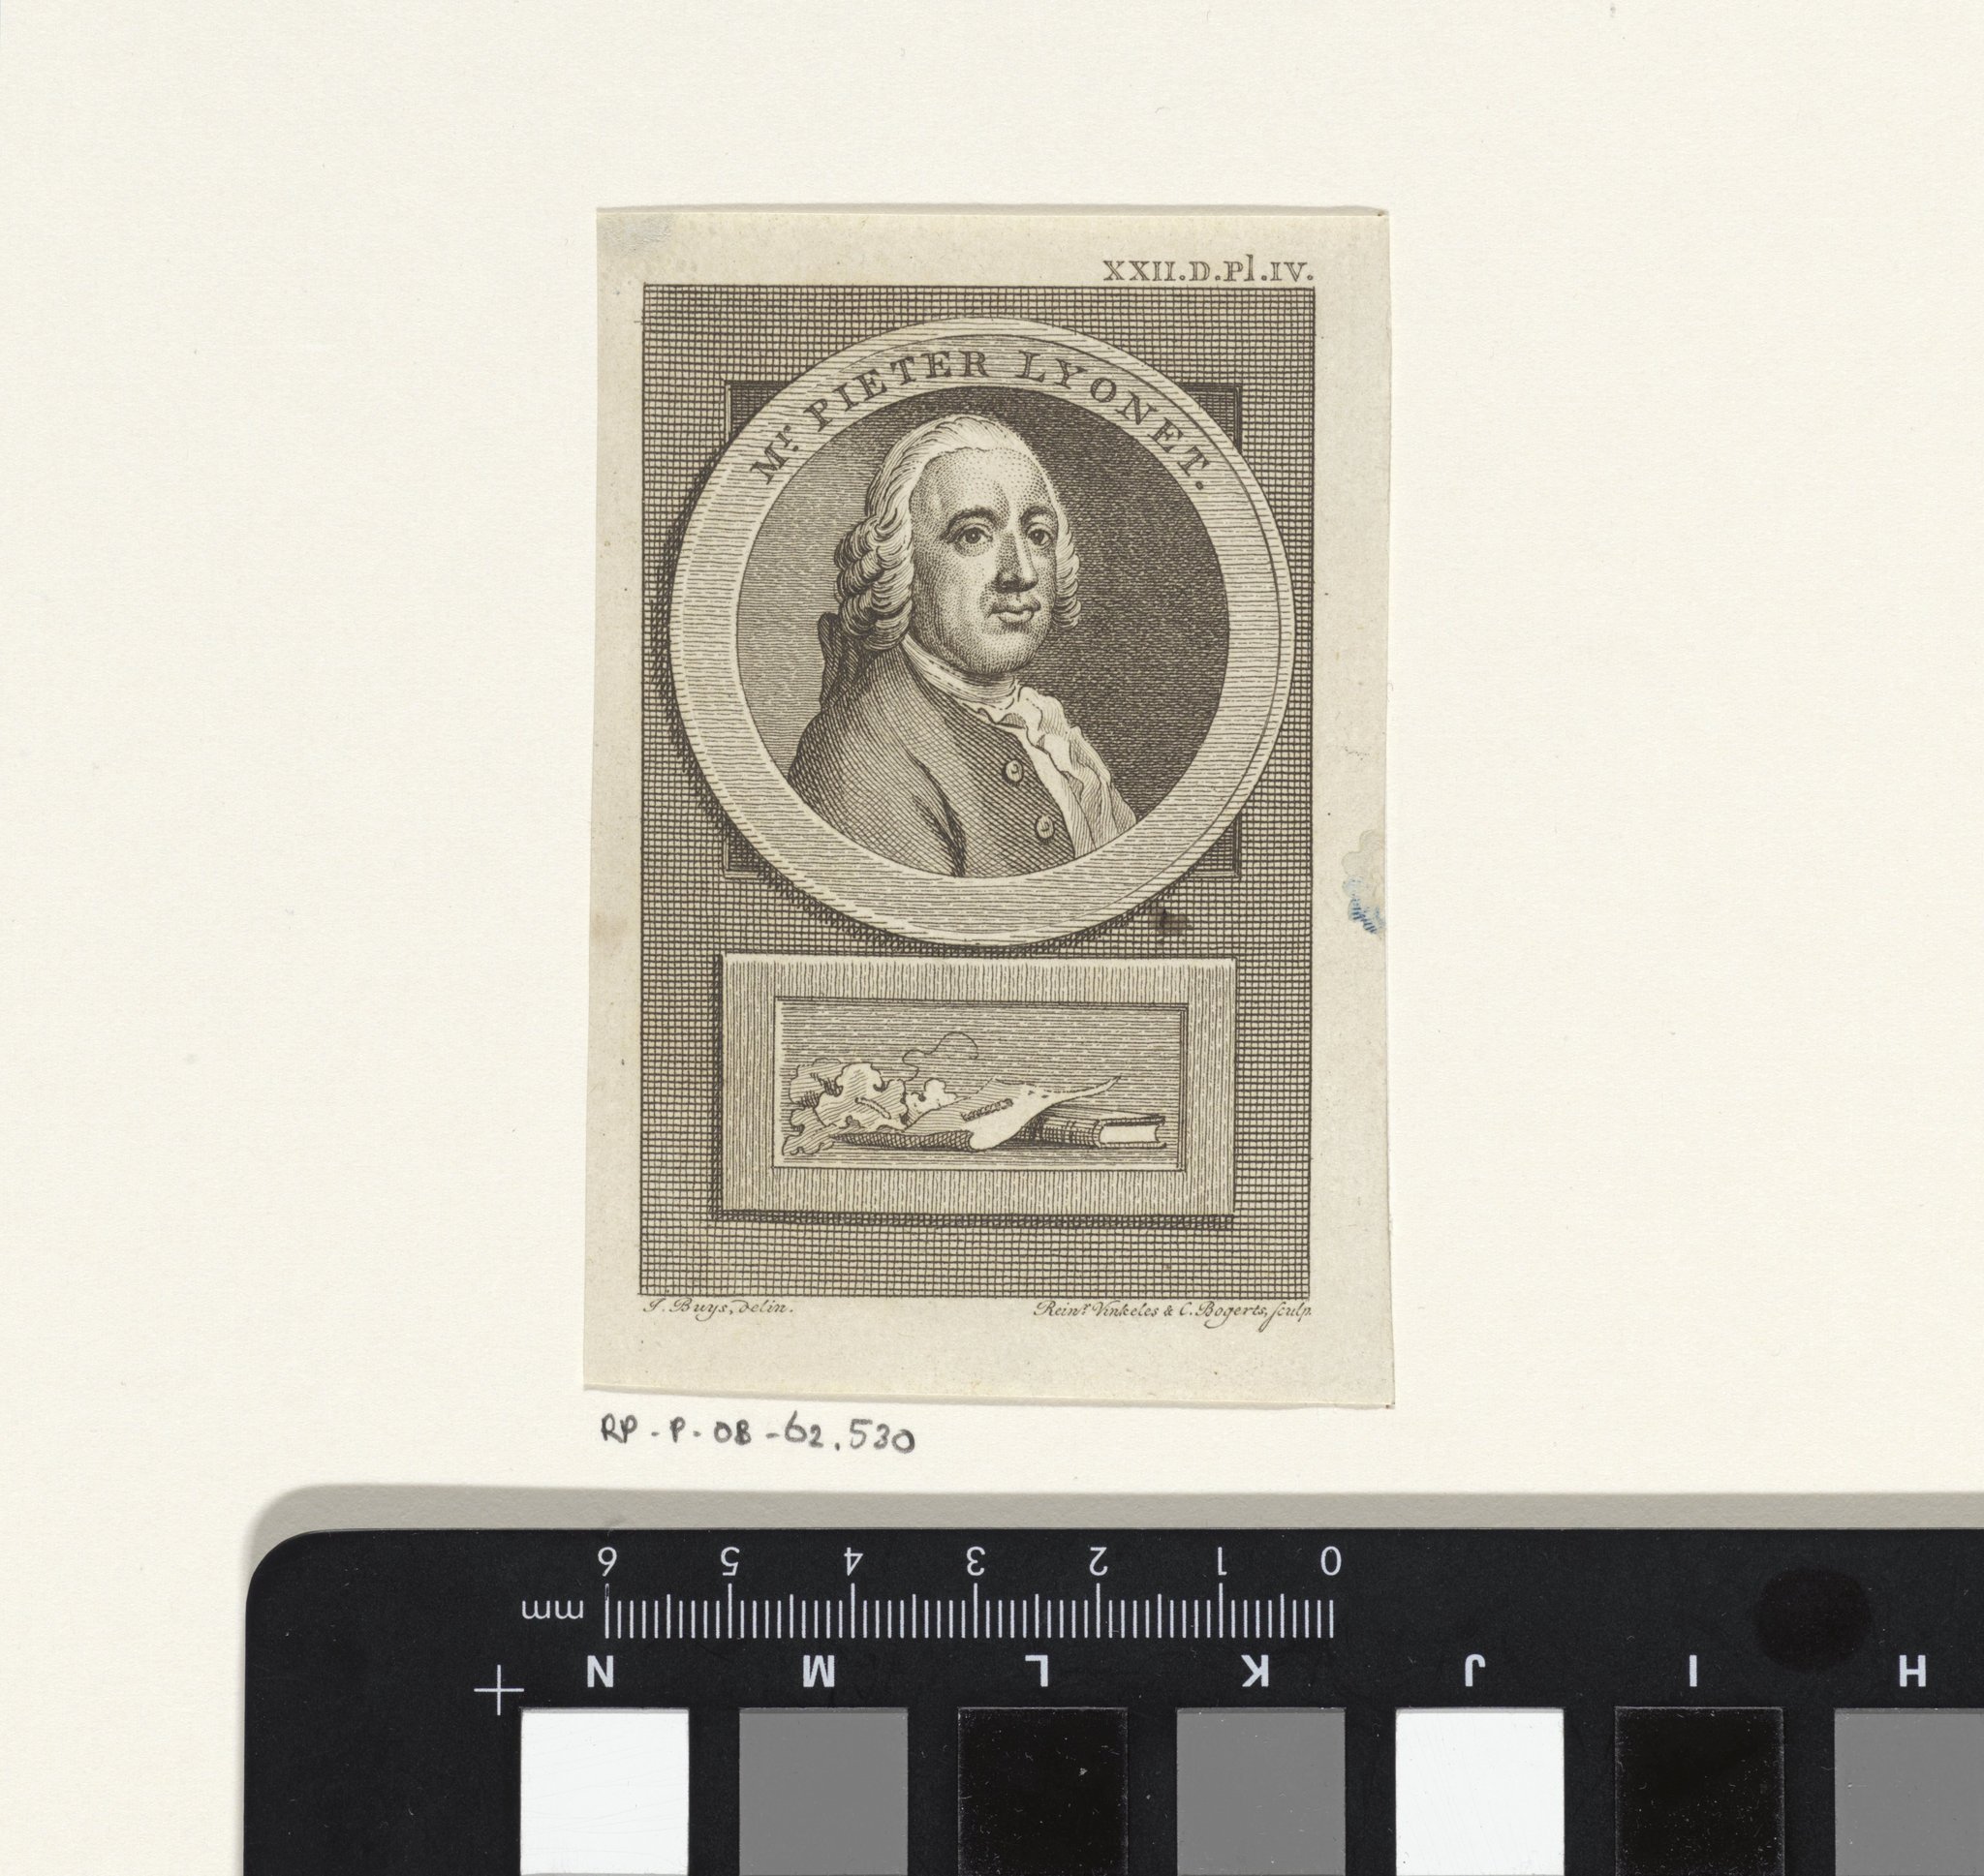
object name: book illustration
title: Portret van Pieter Lyonet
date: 1783-1795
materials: paper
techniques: engraving, etching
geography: amsterdam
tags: the hague, print maker, draughtsman, pieter lyonet, drawing, sketch, trees: oak (+ leaf), book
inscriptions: collector's mark: Lugt 2228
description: Prent gebruikt in: Fokke, Jan. Geschiedenissen der Vereenigde Nederlanden voor de vaderlandsche jeugd Ie-XXVste deel. Amsterdam: Johannes Allart, 1783-1795. Deel XXII.